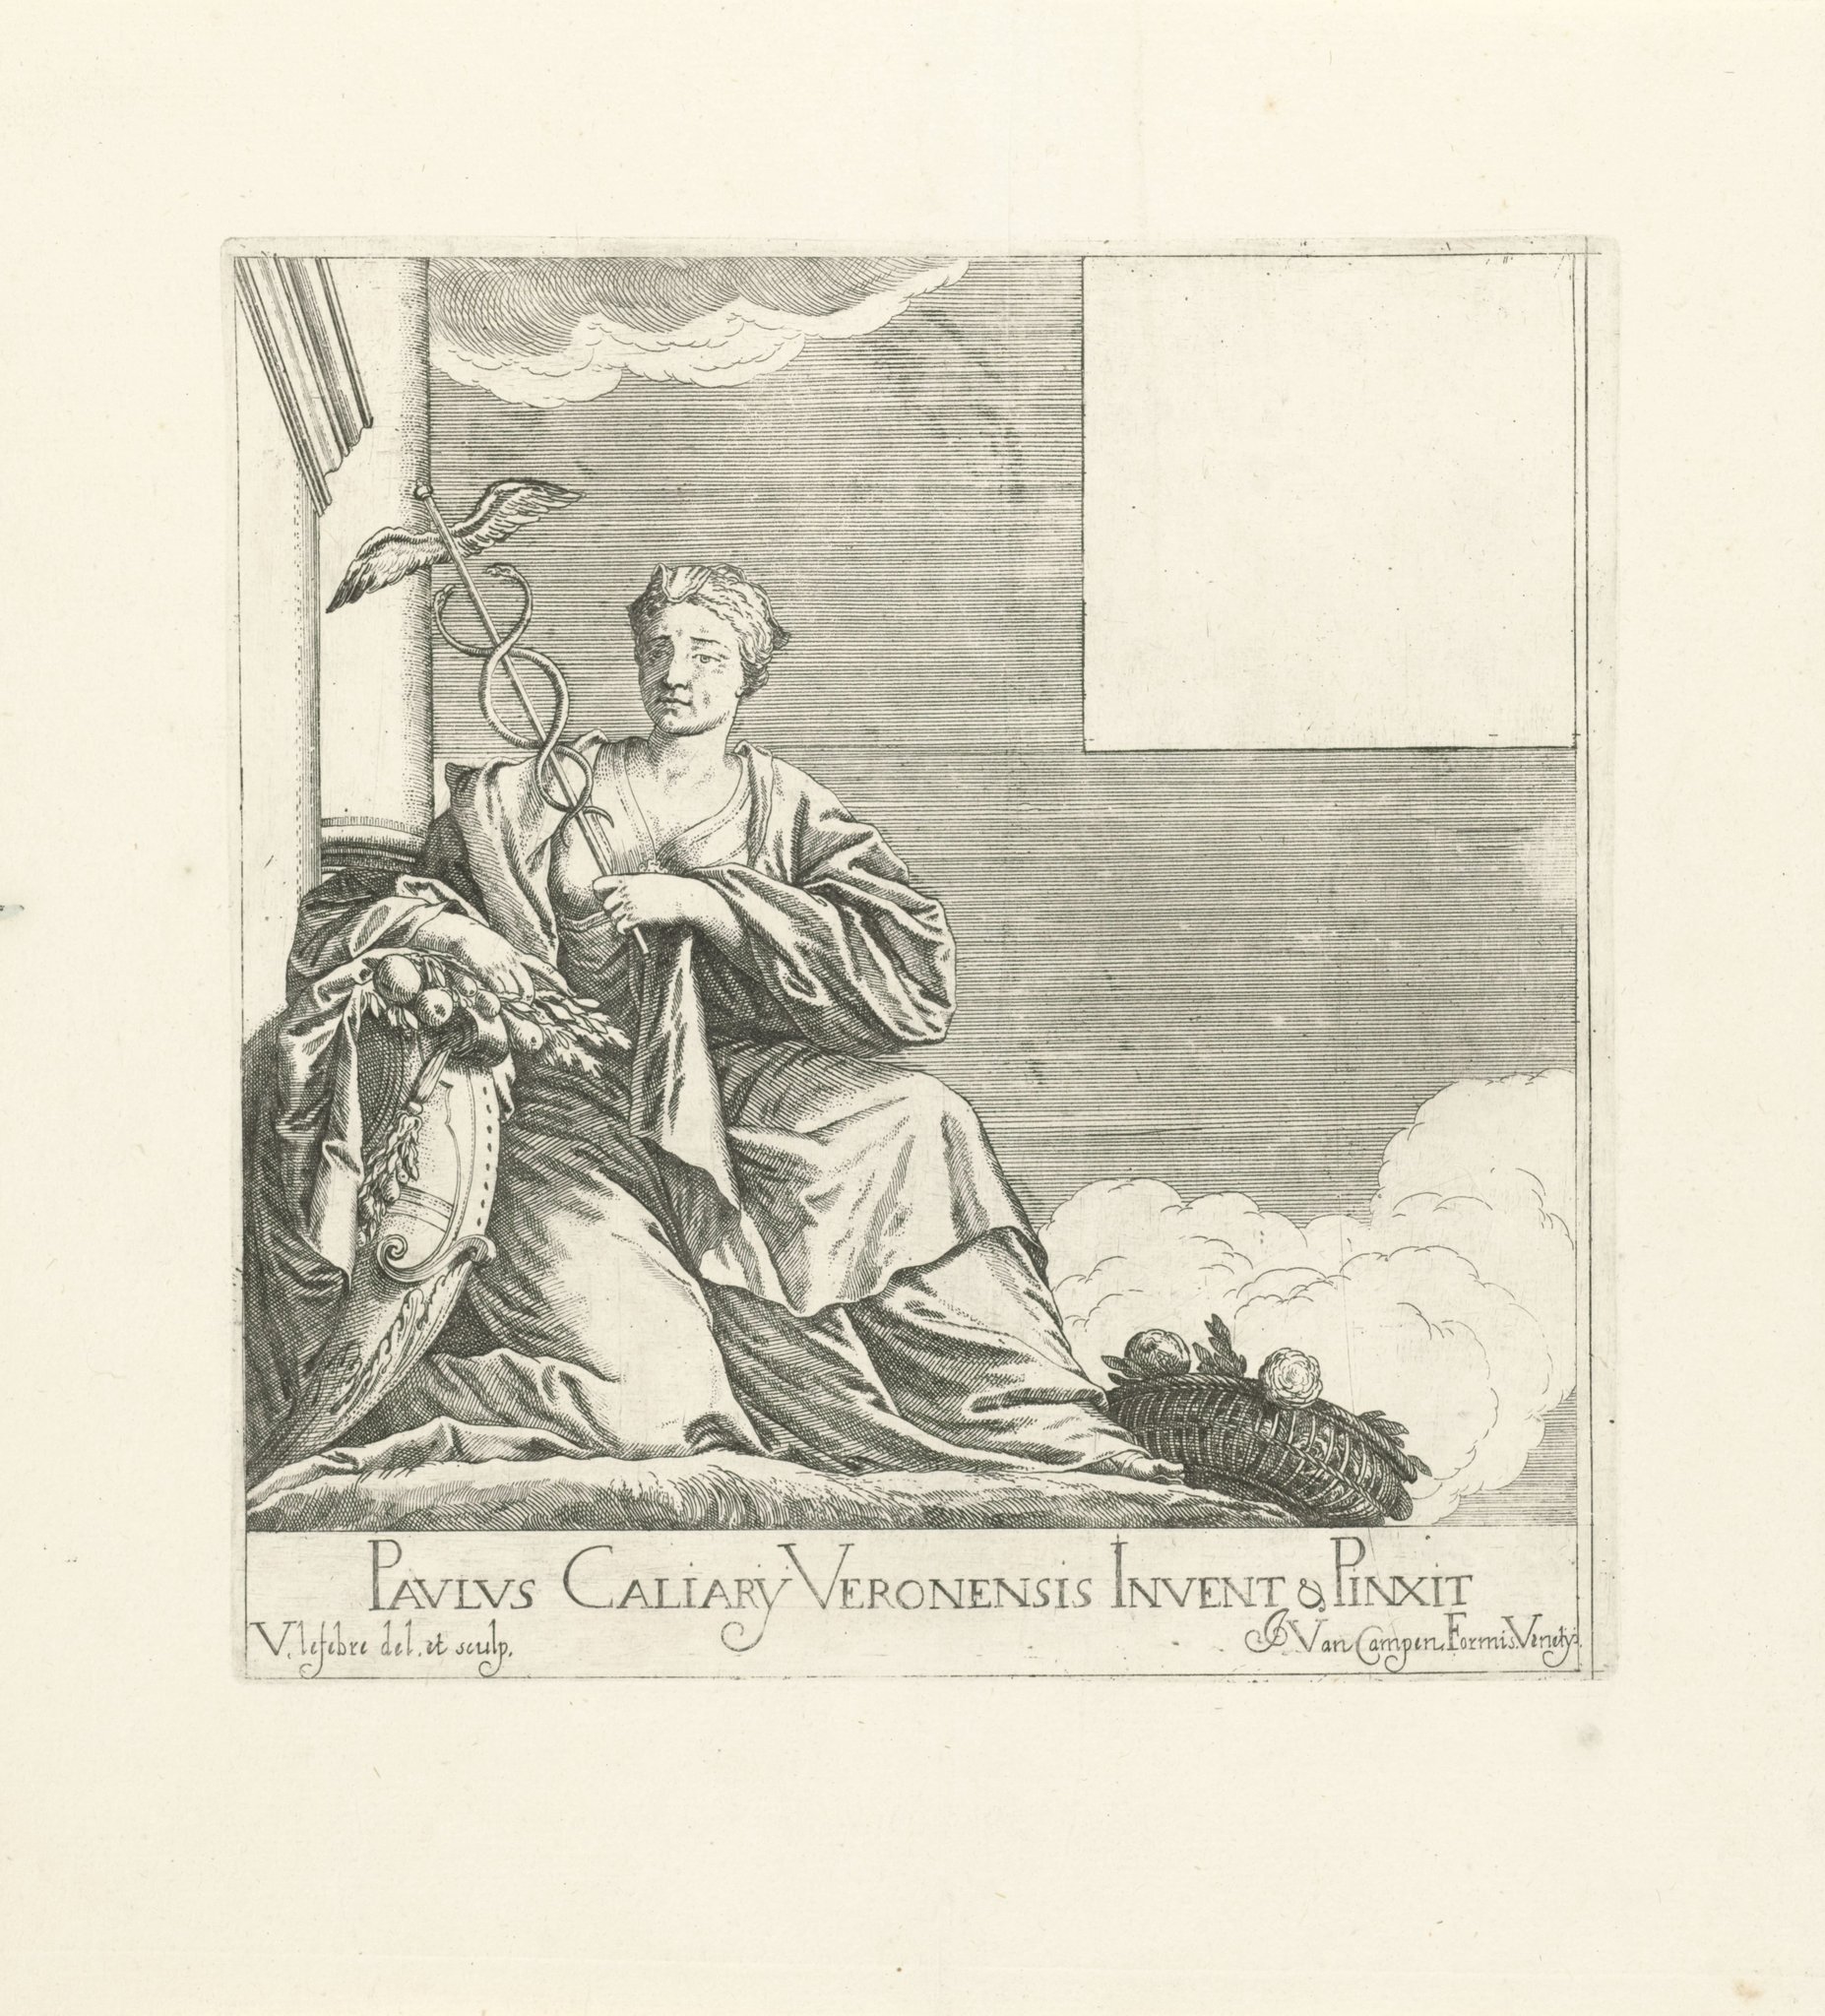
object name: print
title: Voorspoed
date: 1682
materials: paper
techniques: etching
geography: venice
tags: welfare, prosperity; 'felicità publica', 'prosperità della vita', 'salute' (ripa)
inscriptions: collector's mark: Lugt 2228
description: De gepersonifieerde voorspoed (Prosperità) leunt met een caduceus in haar handen op een met vruchten versierd wapenschild. Aan haar voeten een mand met bloemen. De prent maakt deel uit van een 53-delige serie prenten naar schilderijen van Titiaan en Veronese.